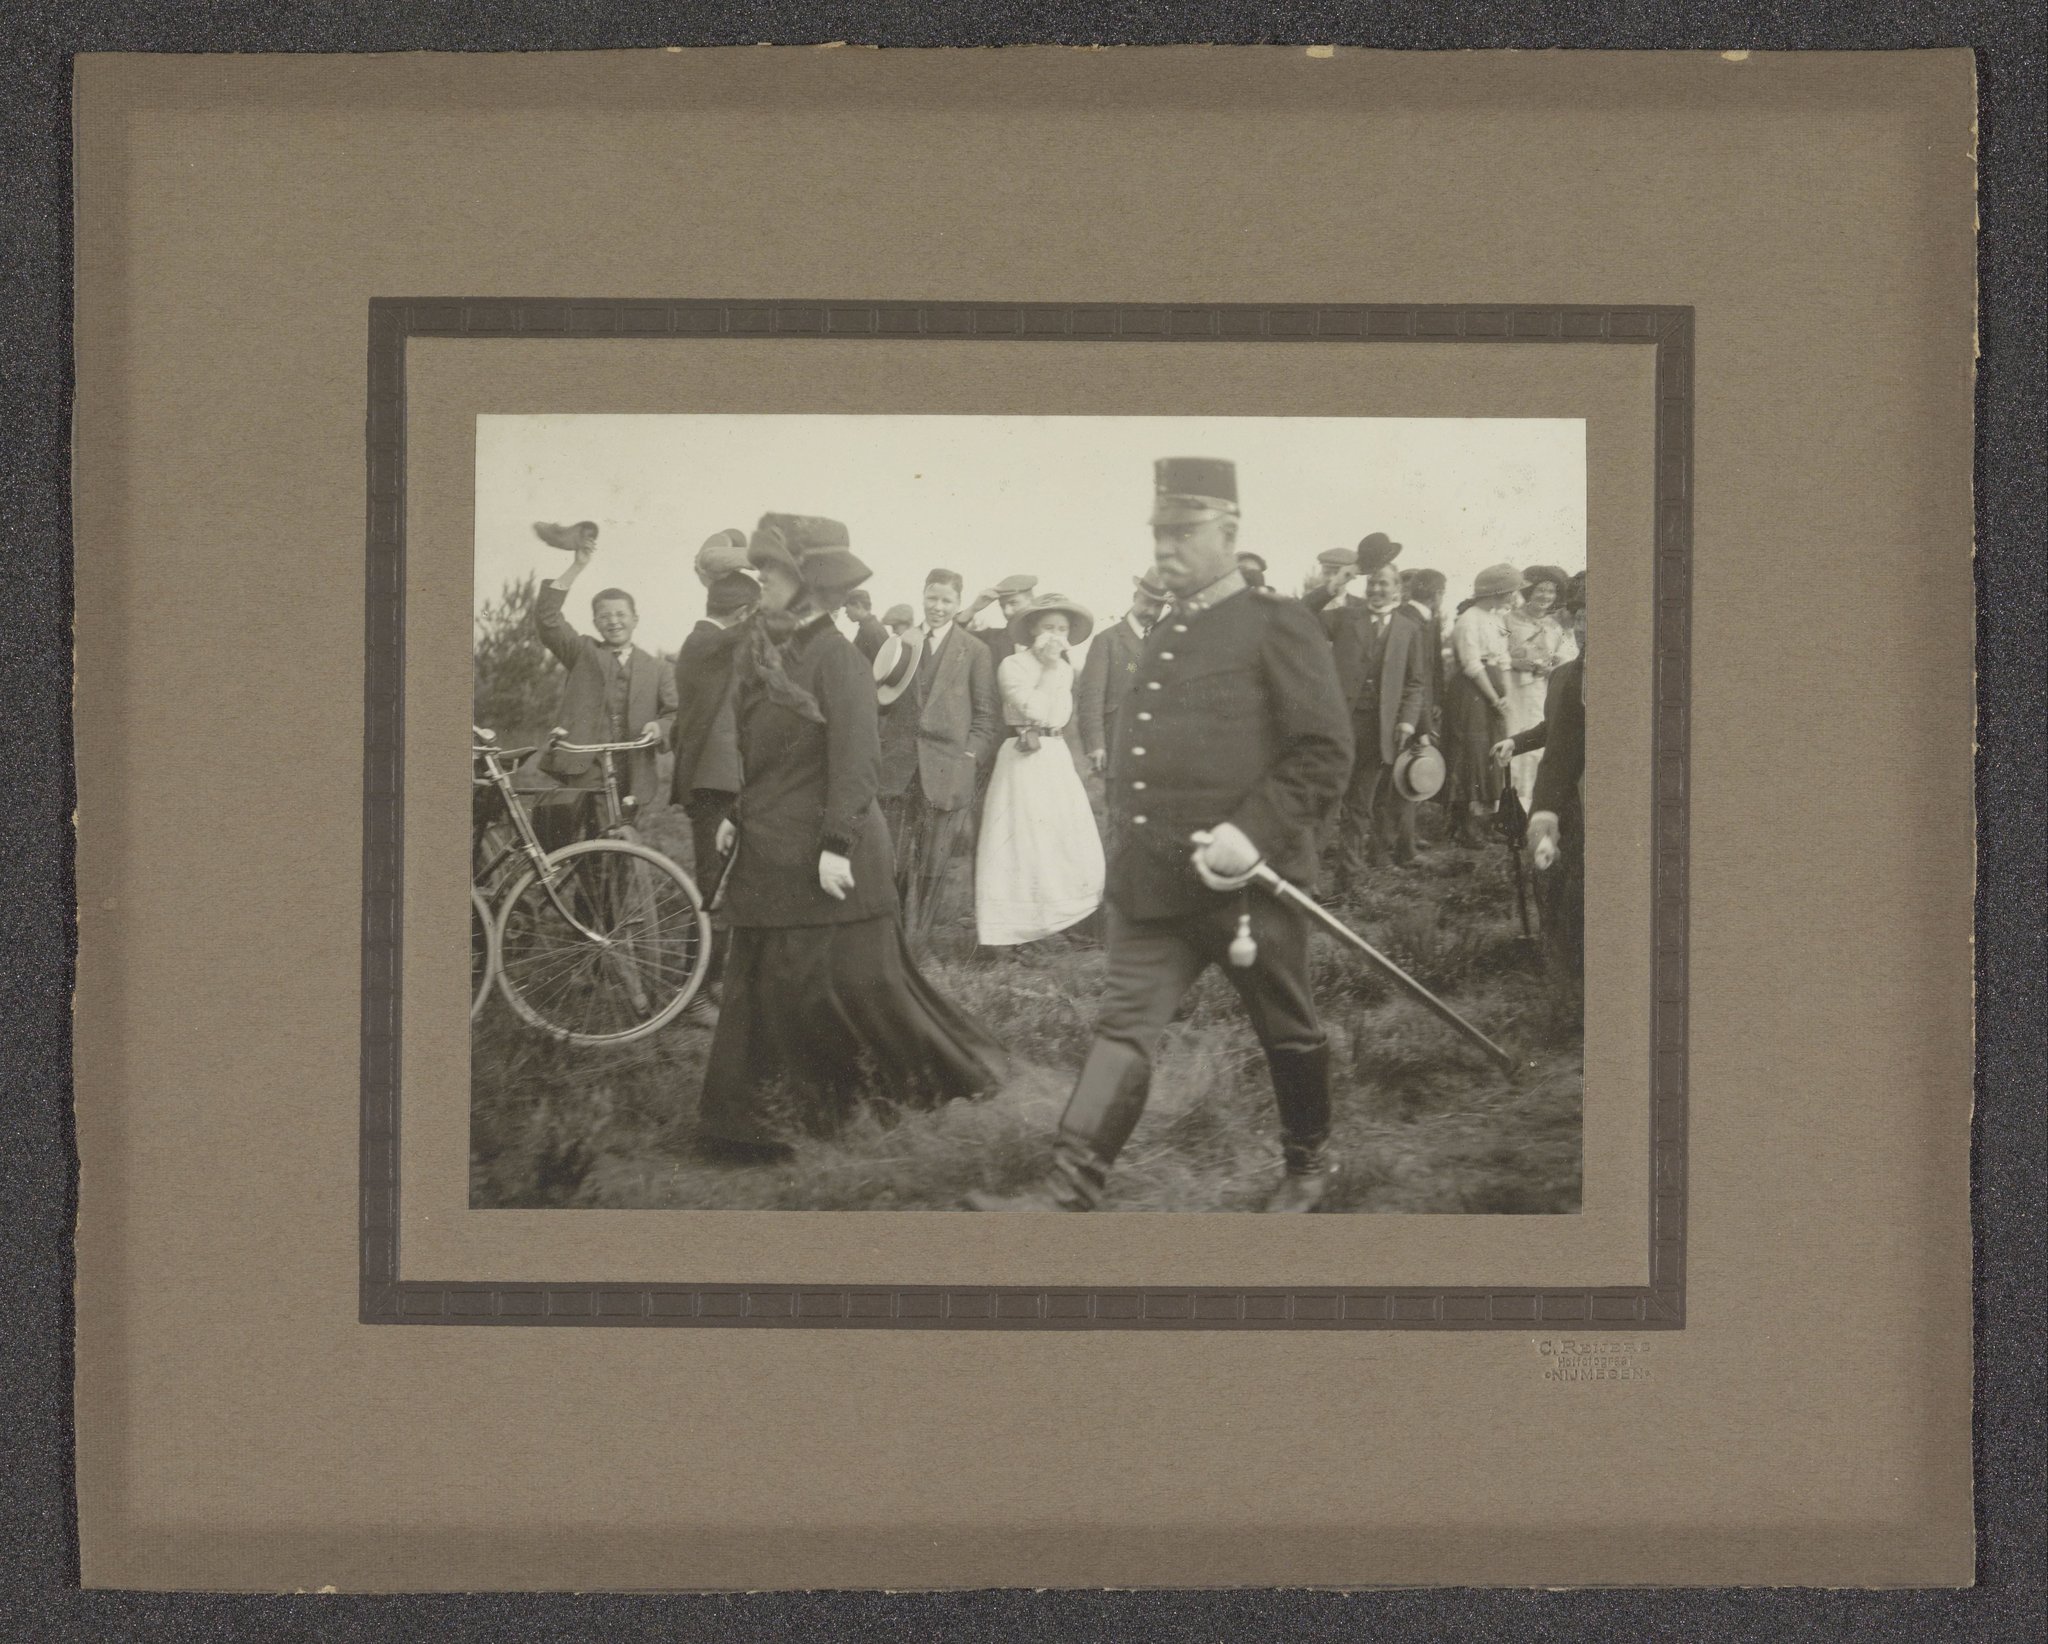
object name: photograph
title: Koningin Wilhelmina loopt door een veld onder begeleiding van de veldwacht.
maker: coenradus hendrikus johannes reijers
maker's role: fotograaf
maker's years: 1868-1936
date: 1912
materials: cardboard, photographic support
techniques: gelatin silver print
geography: nijmegen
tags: the hague, print maker, wilhelmina of the netherlands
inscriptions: inscription: ‘13 spet 1912 Dekkerswald ... De Koningin bij de Manoeuvre’